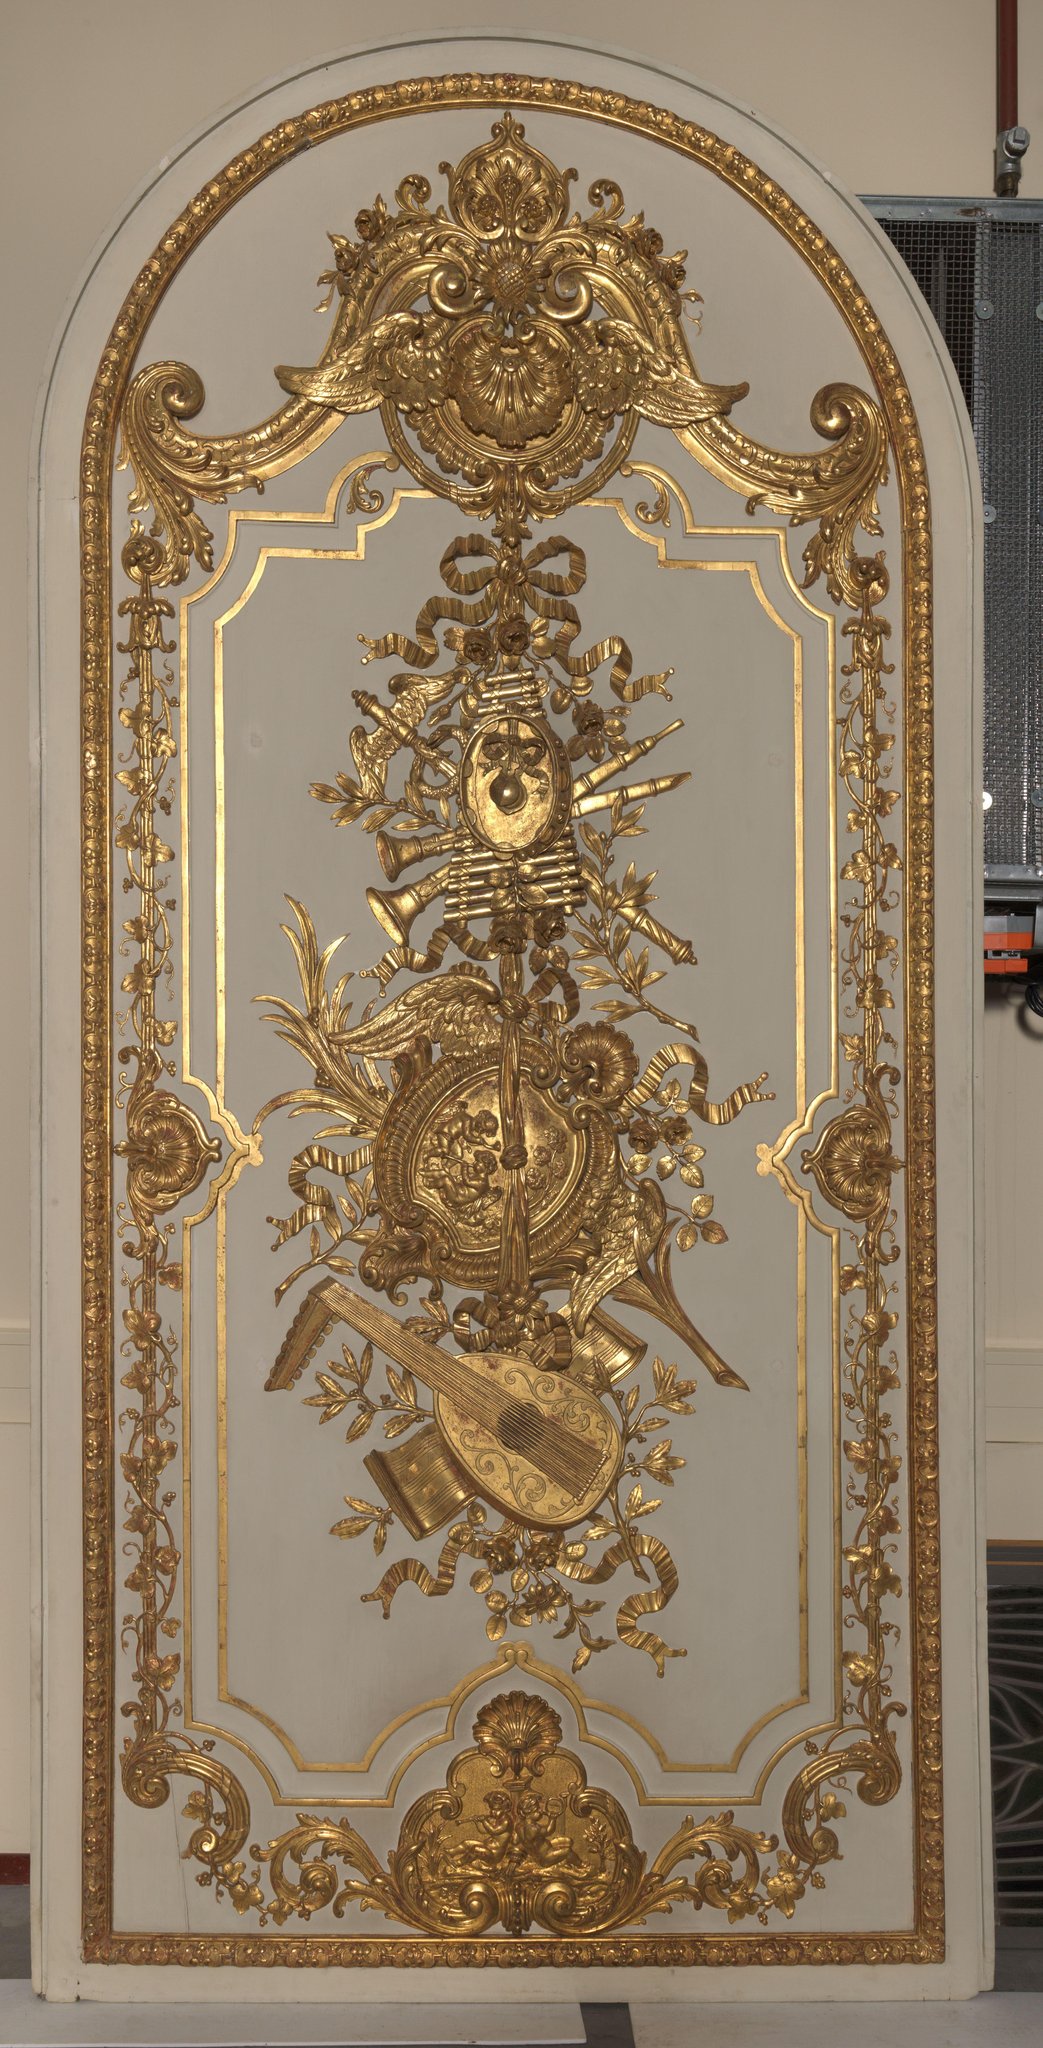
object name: architectural element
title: Paneel van eikenhout in wit en goud geschilderd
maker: j. verberckt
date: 1750-1775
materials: wood, paint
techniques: gilding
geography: france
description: Cornelis Troost (1696 - 1750). The Phoenix. Dessus-de-porte. Wall panel. Oak, painted white and gold. Paris, c. 1750 (?).